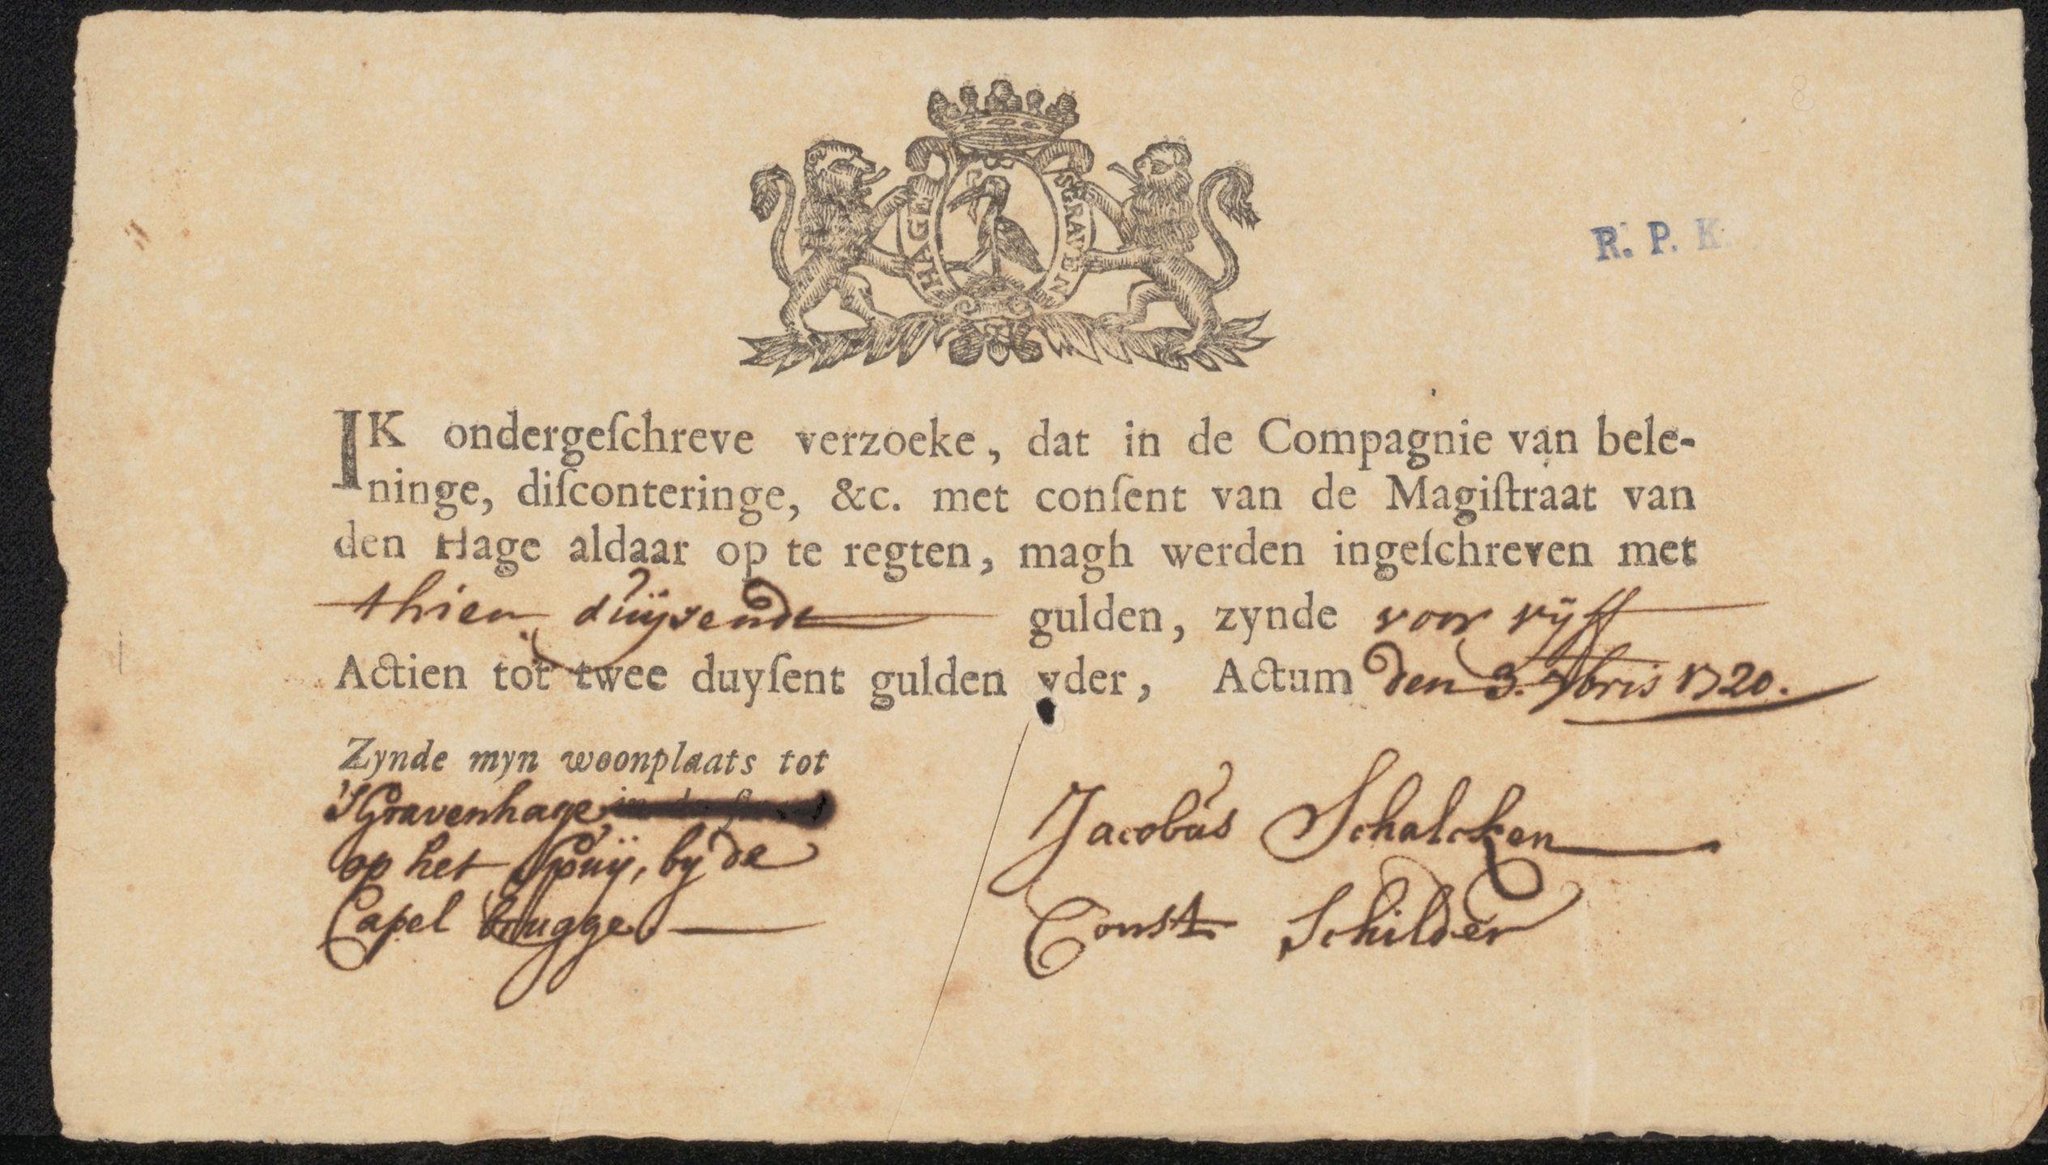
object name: document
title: Inschrijvingsbiljet van Jacob Schalcken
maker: jacob schalcken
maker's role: draughtsman, painter, print maker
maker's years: 1683-1733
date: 1720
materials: ink, paper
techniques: pen, printing, writing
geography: the hague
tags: money, the hague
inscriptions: collector's mark: Lugt 2233